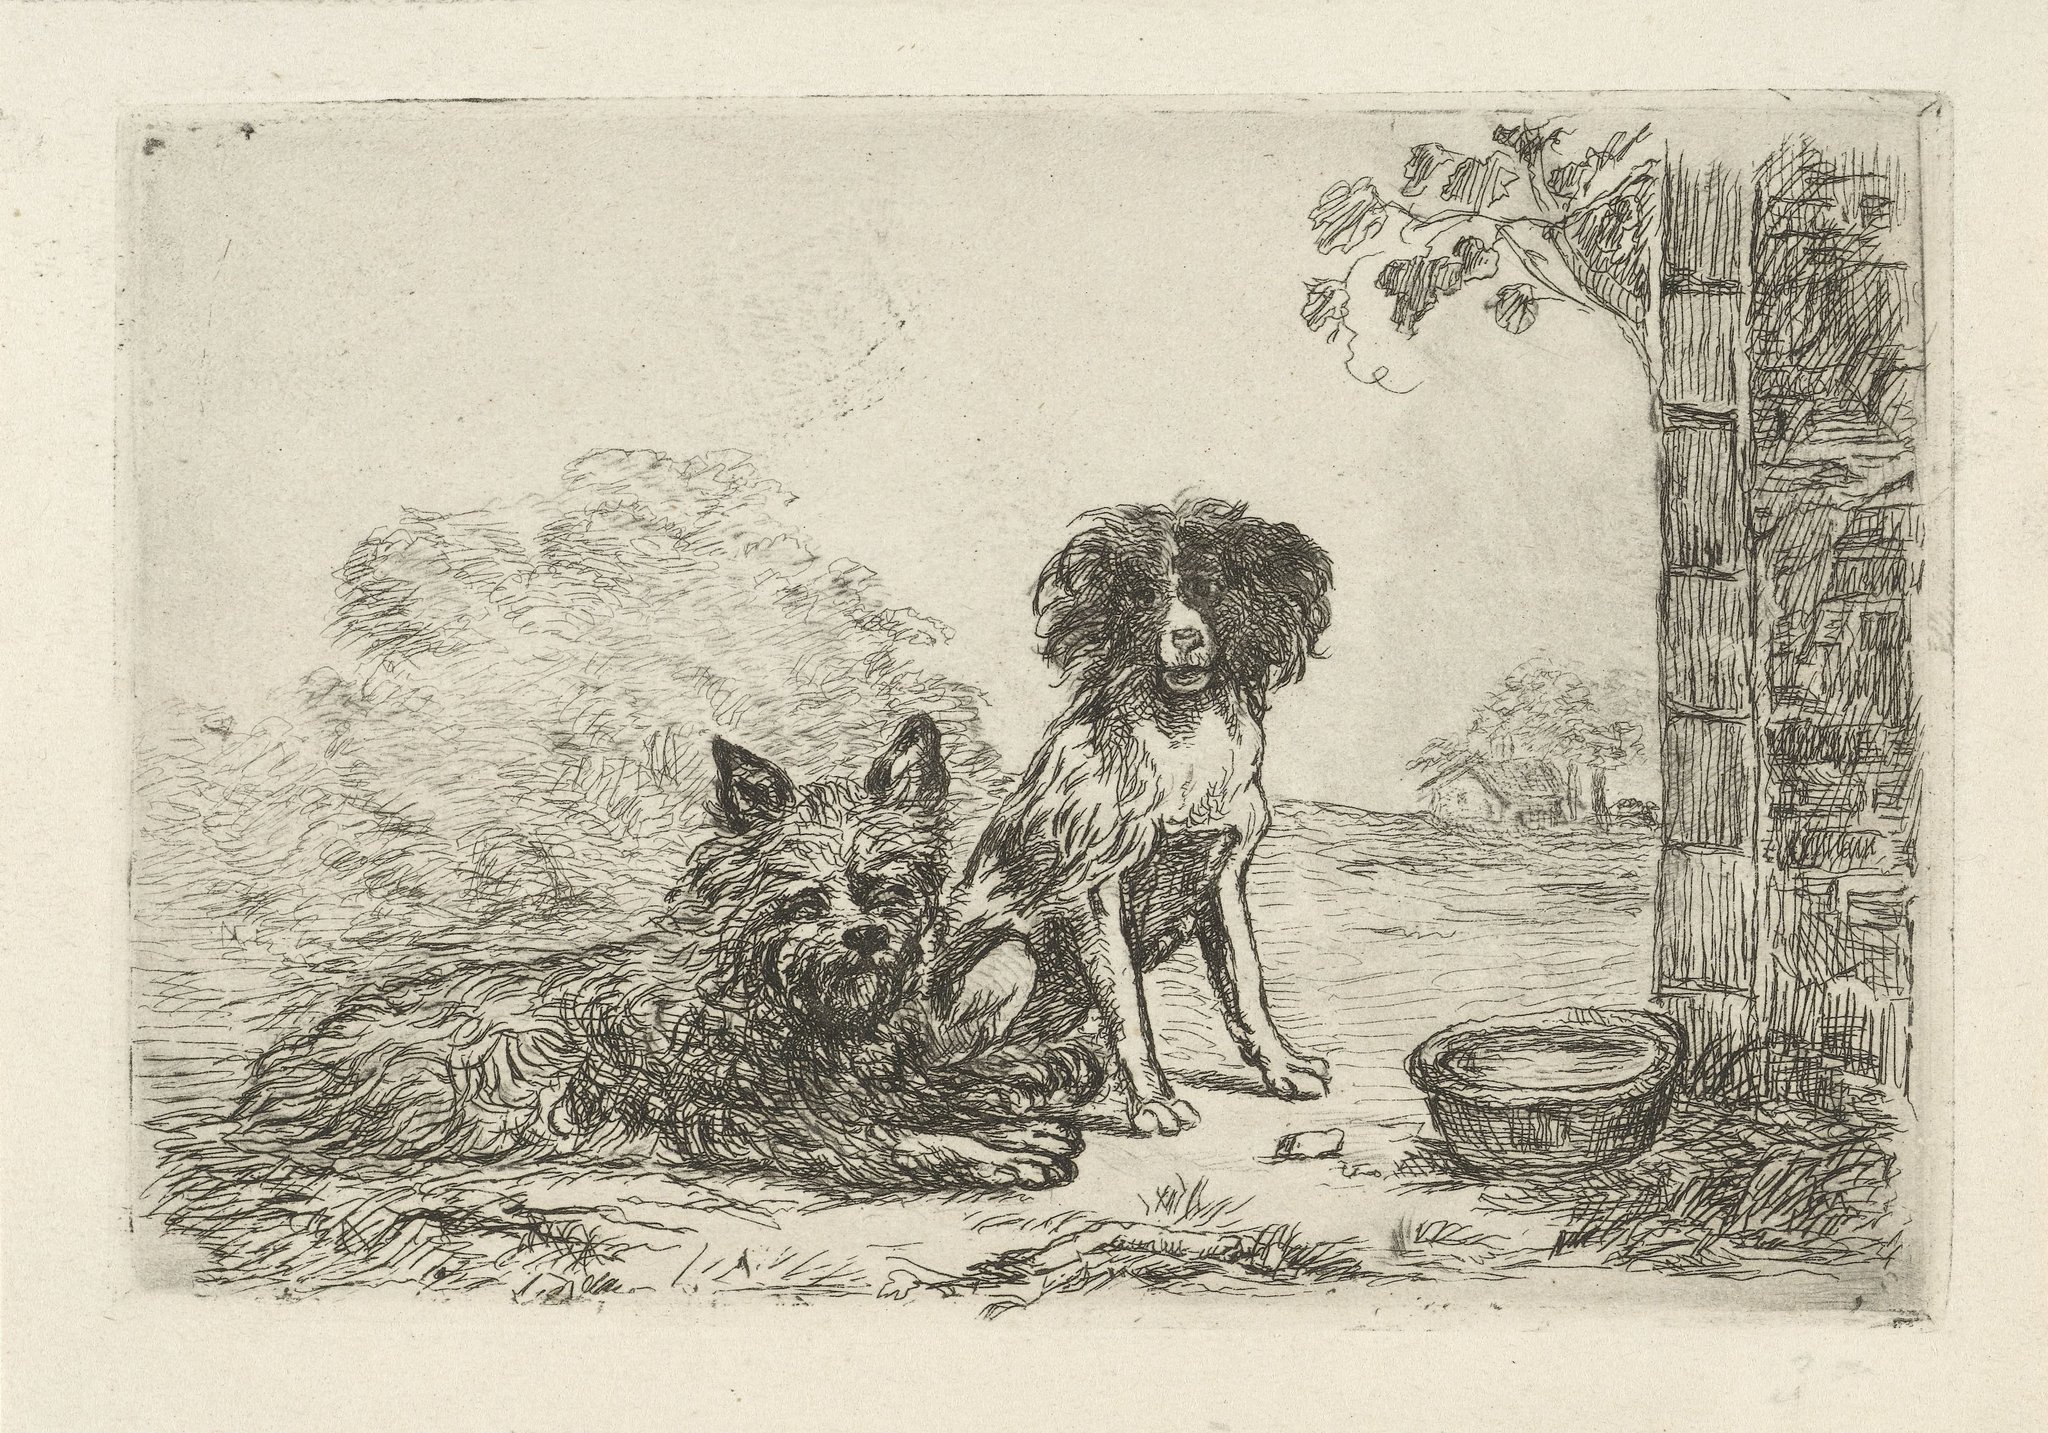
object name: print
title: Twee honden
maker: david van der kellen (1804-1879)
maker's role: die cutter, draughtsman, print maker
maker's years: 1804-1879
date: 1814-1878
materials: paper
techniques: etching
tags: landscapes, dog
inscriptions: collector's mark: Lugt 2228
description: In de openlucht zitten twee honden voor een huis bij een bak met water. Op de achtergrond een boerenhoeve en een aantal bomen.